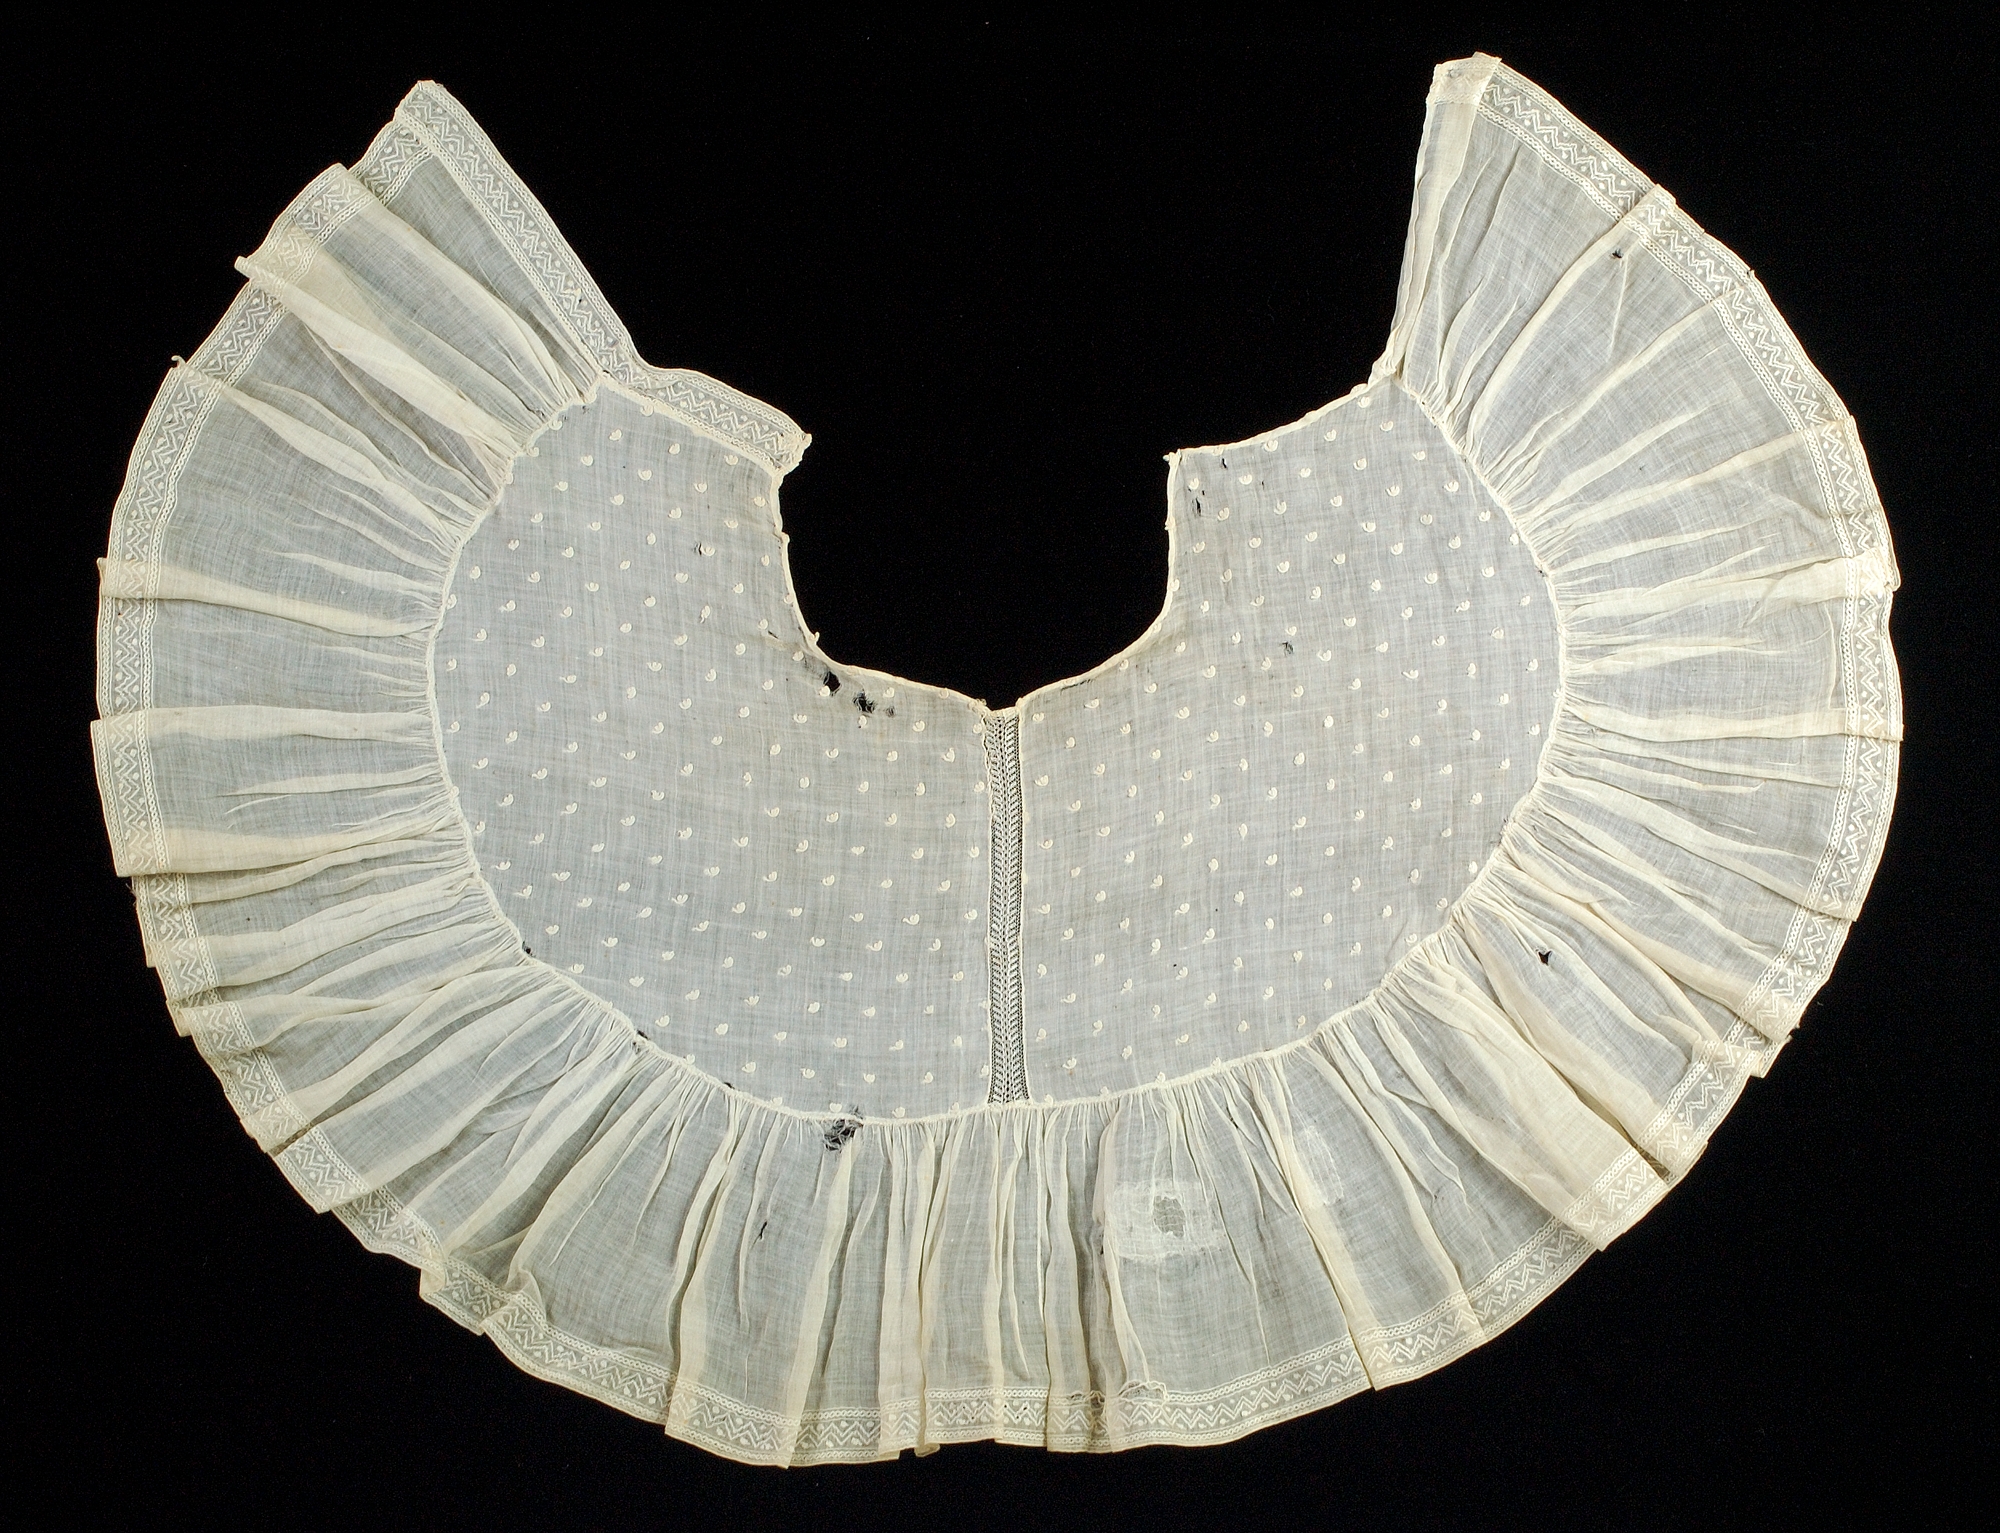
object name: collar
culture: american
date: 1801-1833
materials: cotton